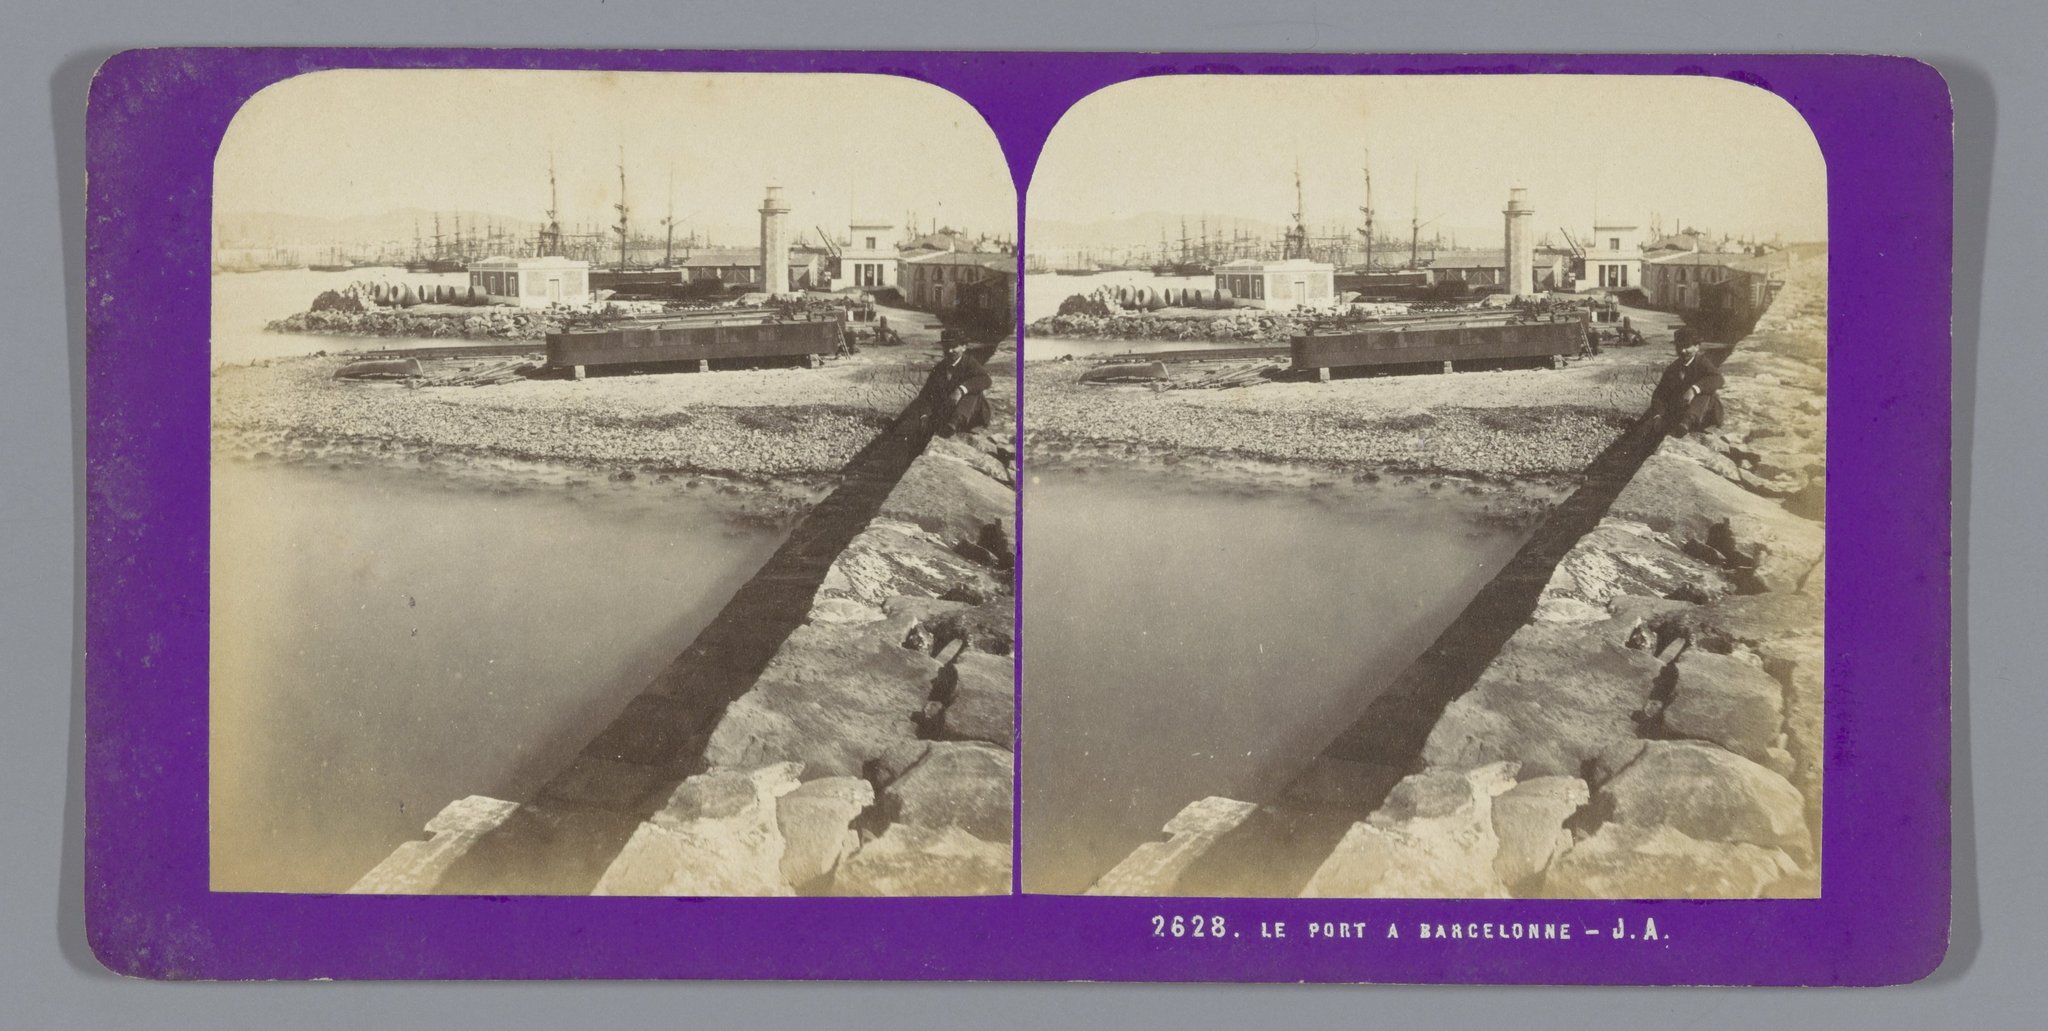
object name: stereograph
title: Gezicht op de haven van Barcelona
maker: jean andrieu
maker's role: fotograaf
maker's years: 1816-1872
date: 1862-1876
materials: cardboard, photographic support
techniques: albumen print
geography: barcelona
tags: harbour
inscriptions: number: ‘2628.’